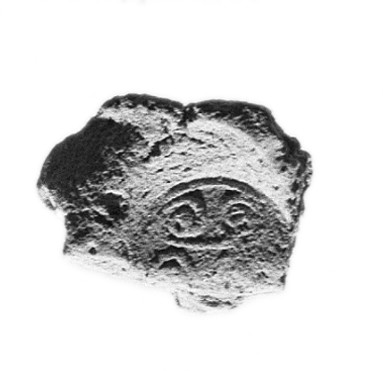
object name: sealing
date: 1981-1640 BCE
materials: mud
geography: egypt